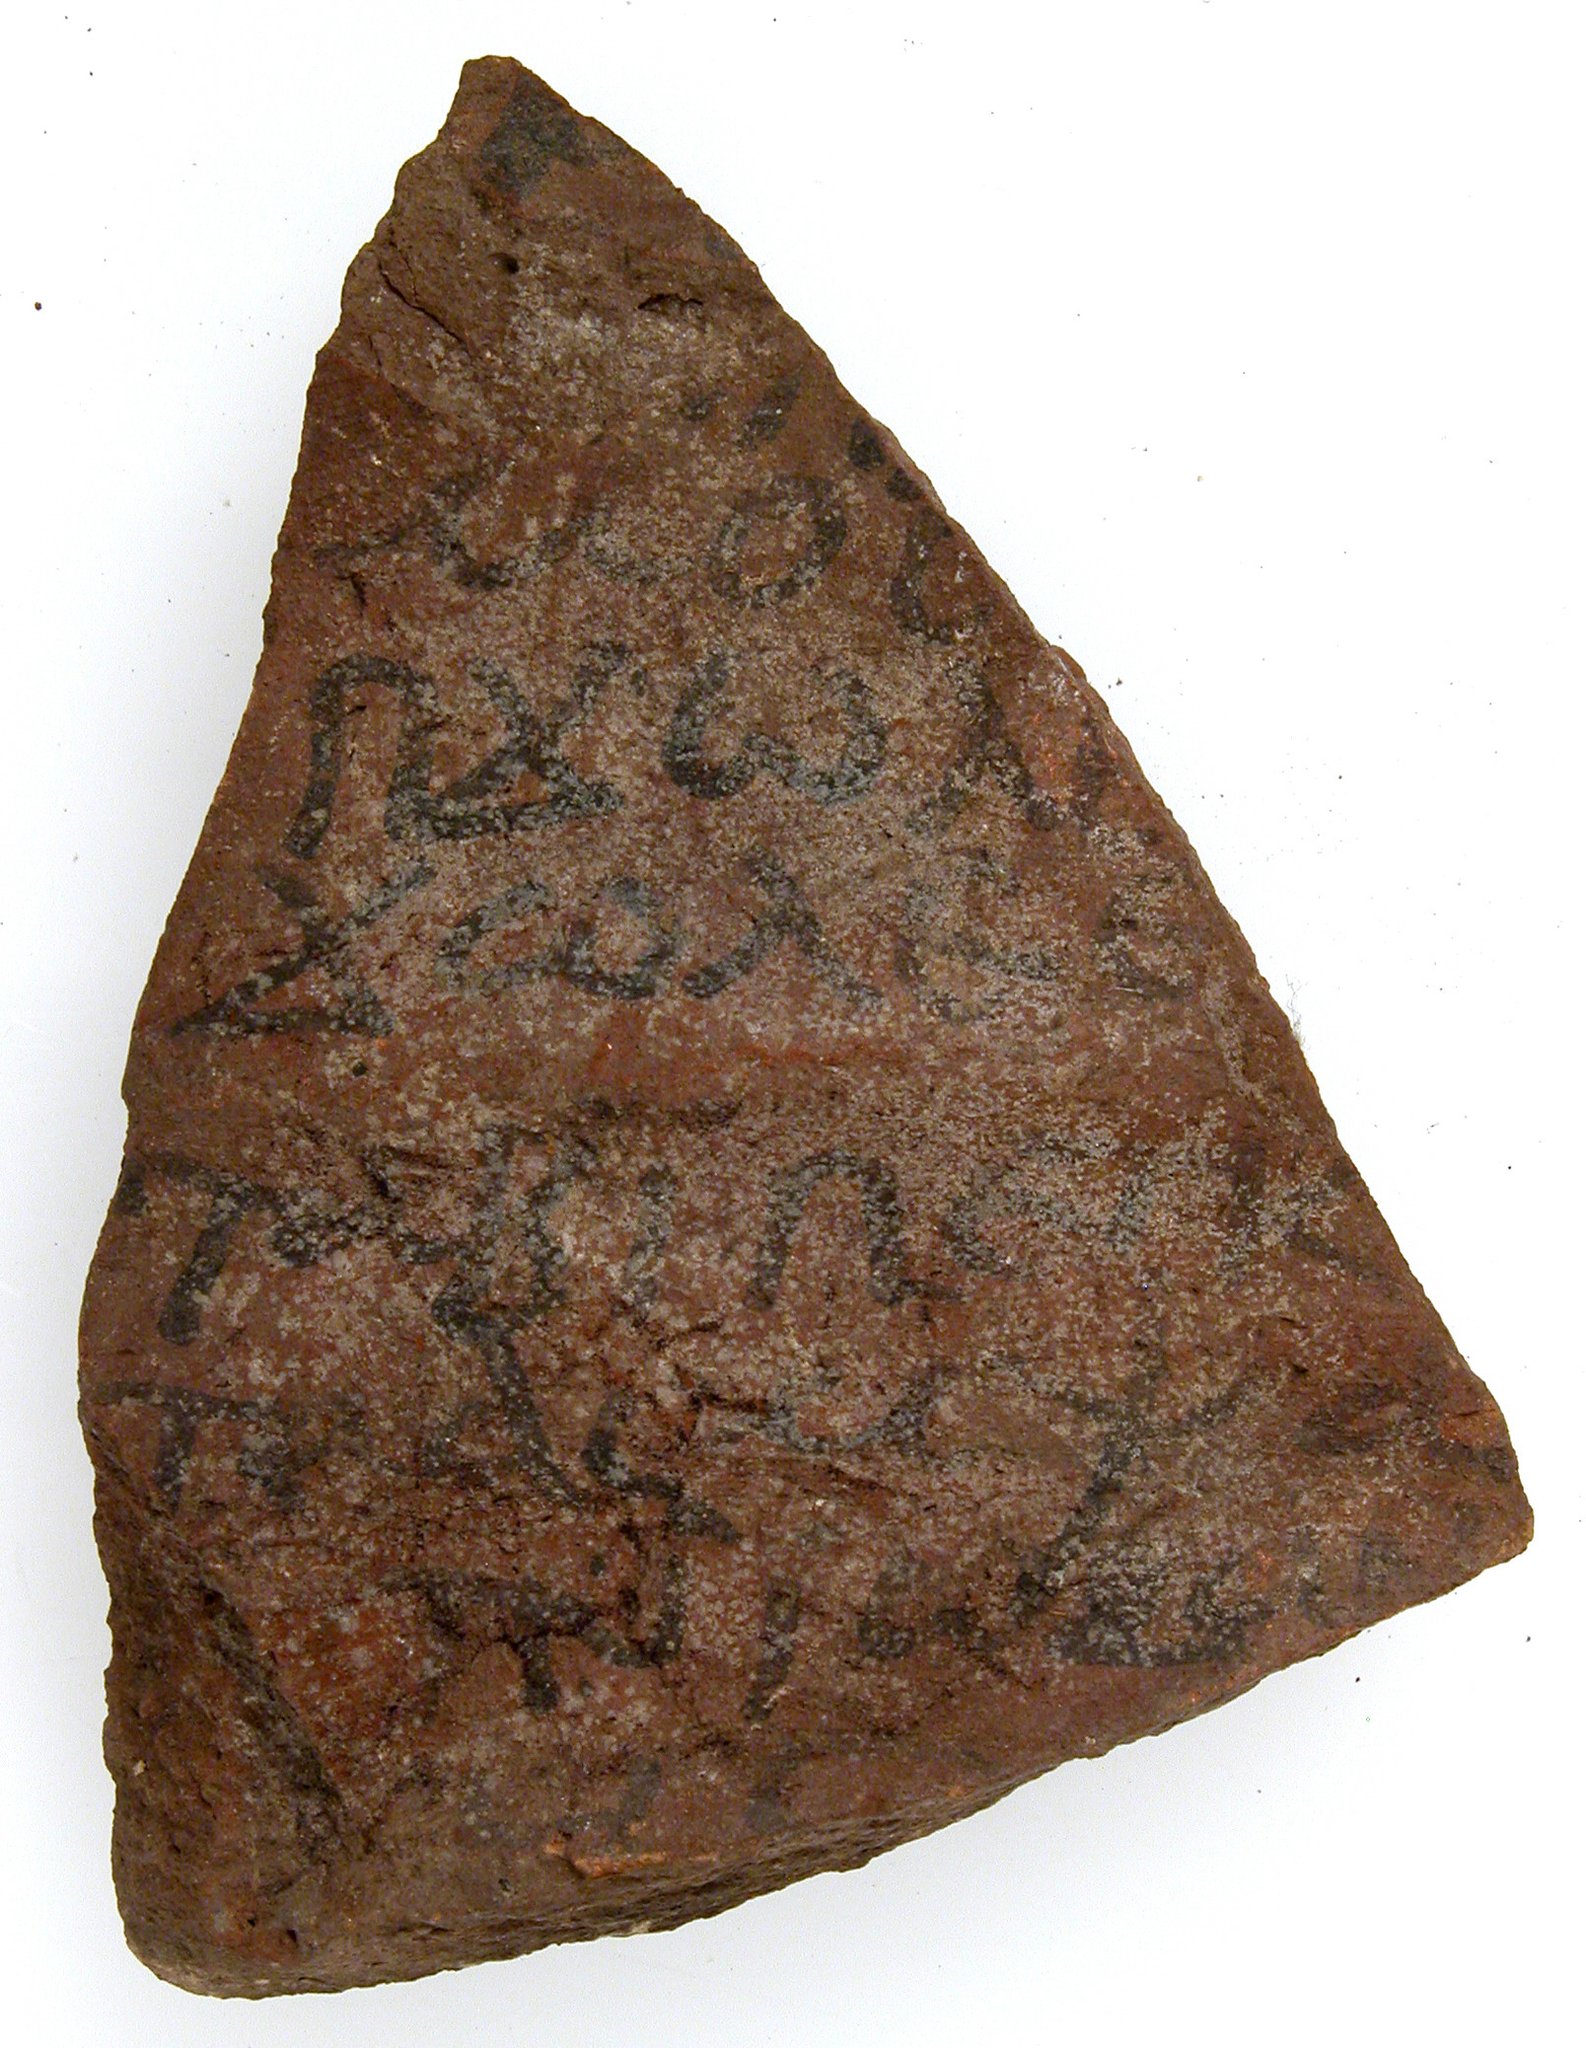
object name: ostrakon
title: Ostrakon with a Letter to Epiphanius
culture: coptic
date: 600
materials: ink, pottery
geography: egypt